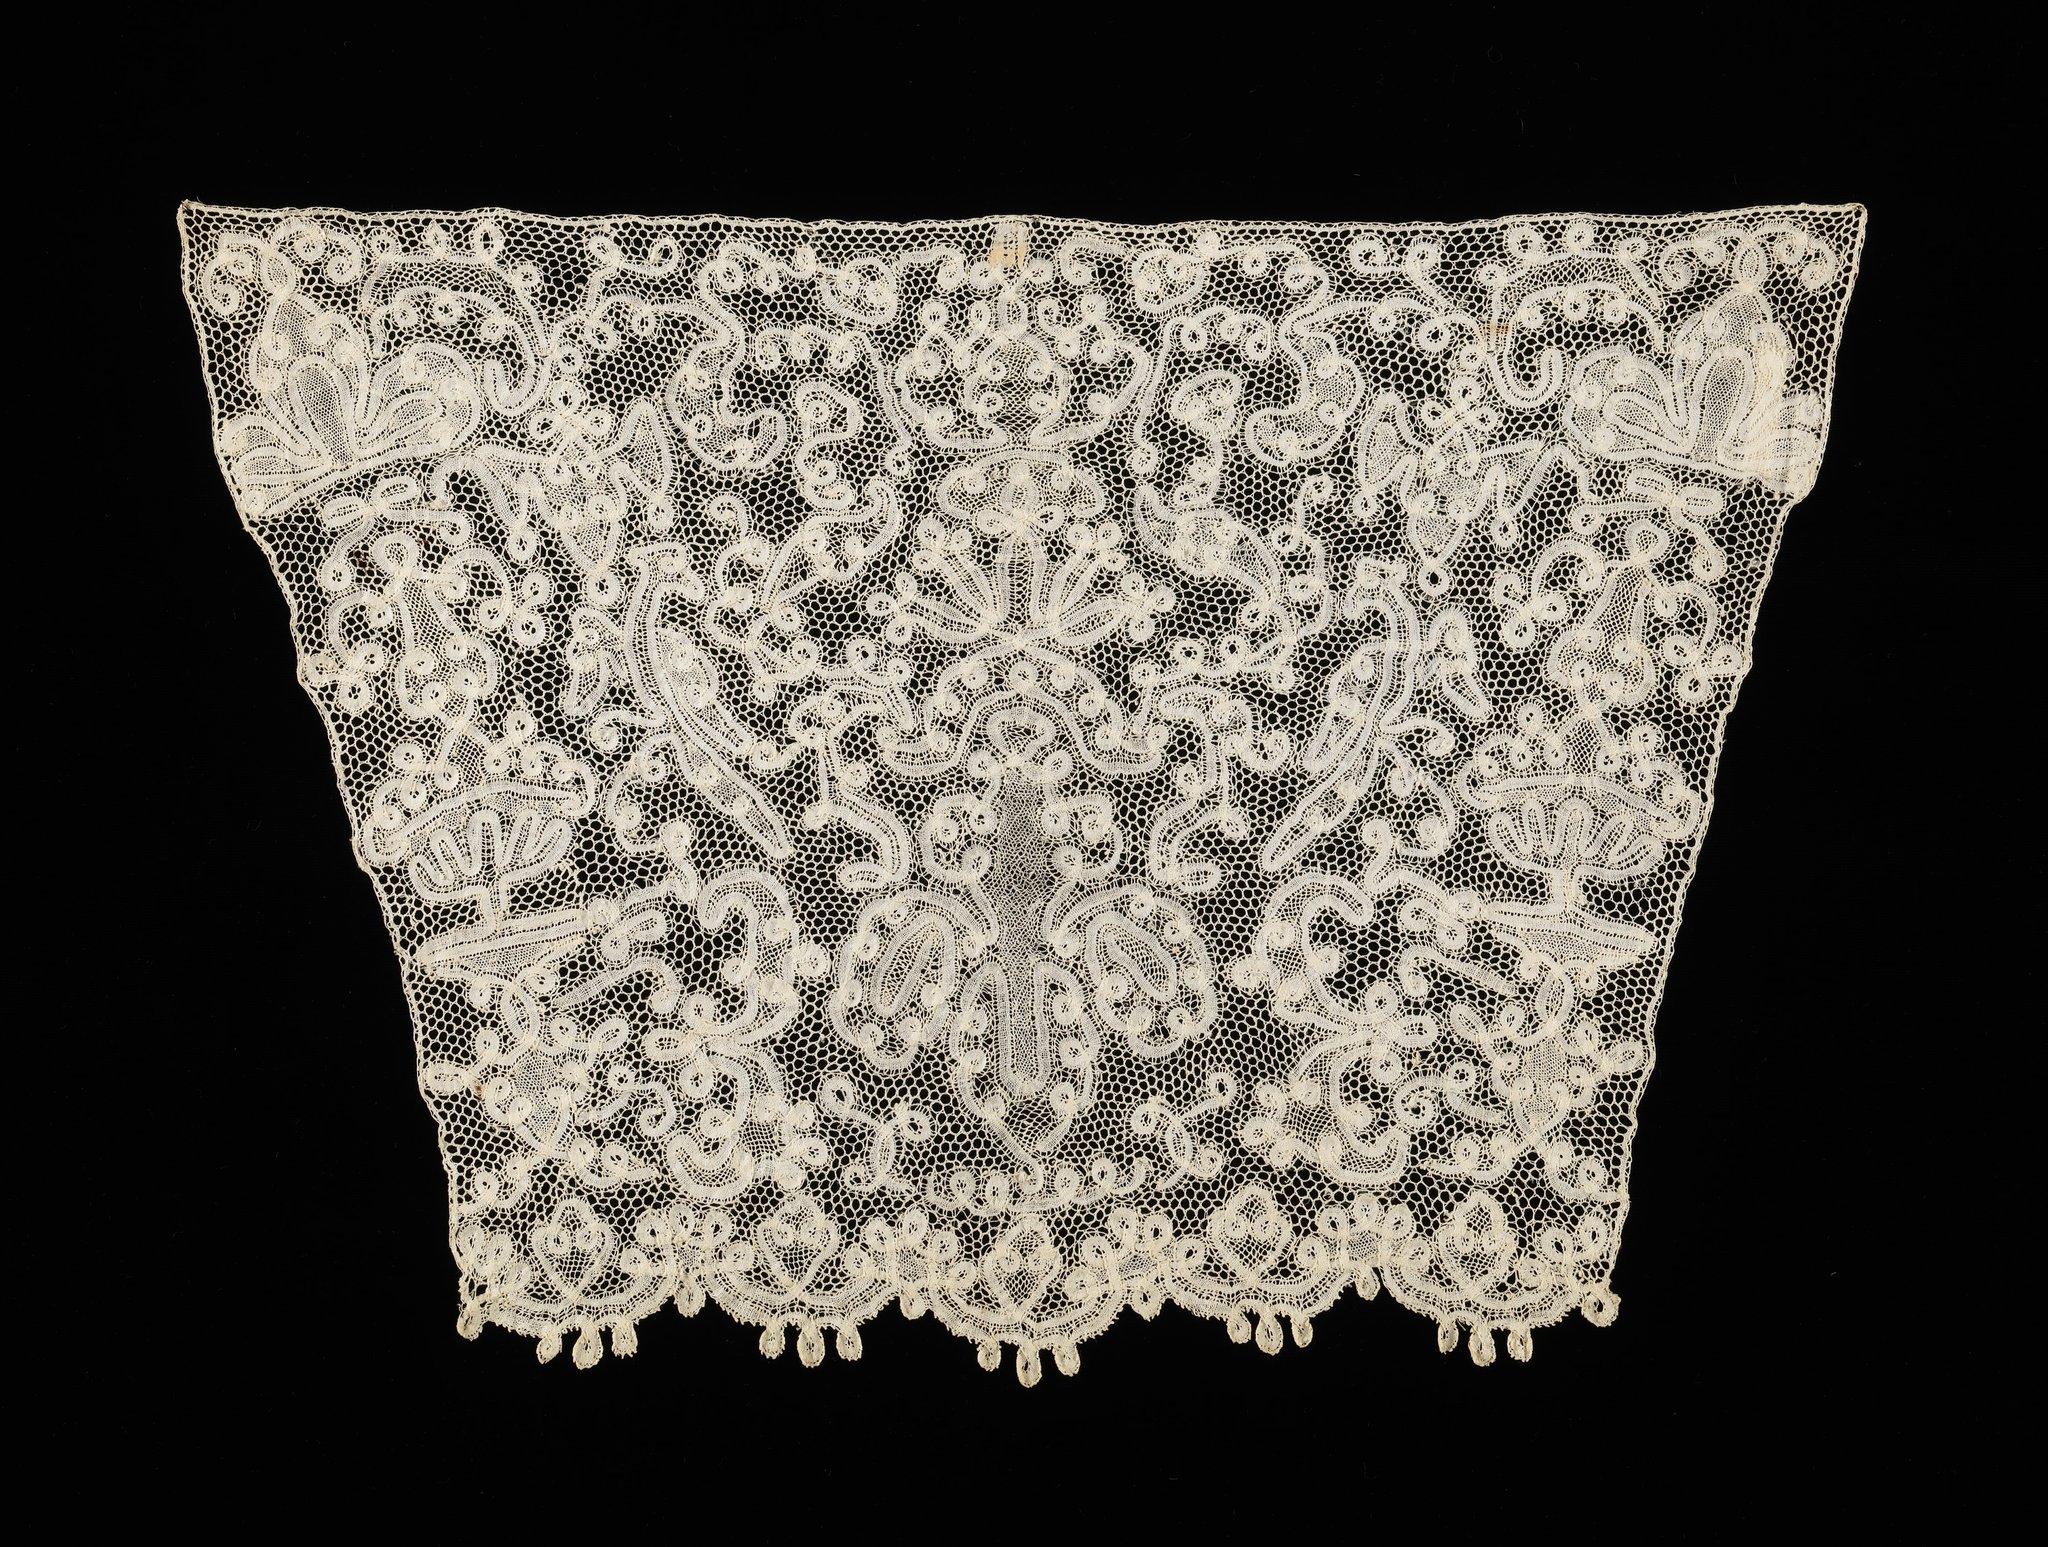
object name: cuff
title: Cuffs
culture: italian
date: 1634-1666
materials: linen